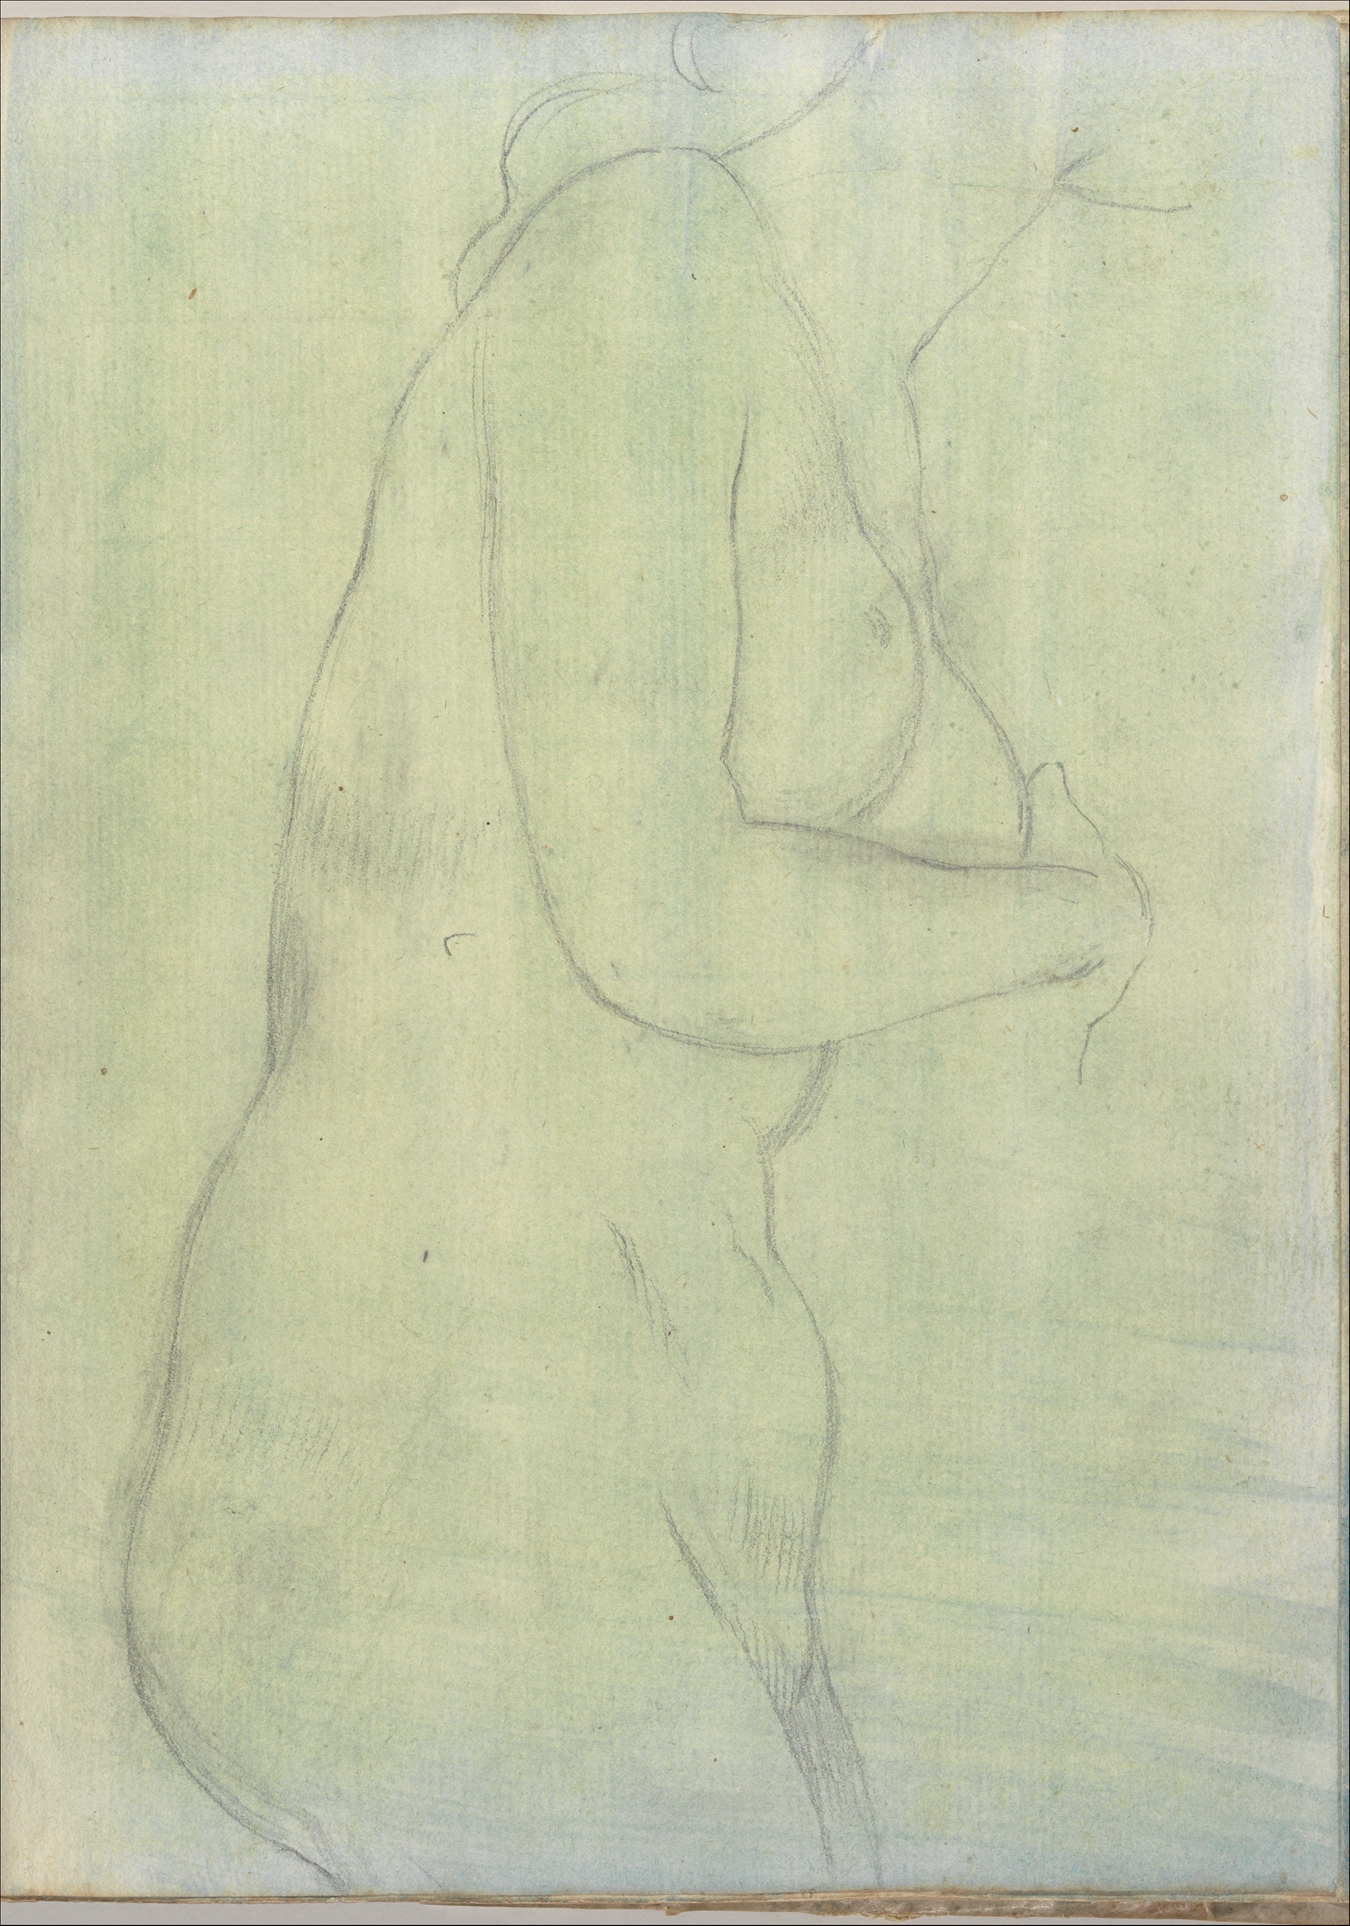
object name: drawing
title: Sketch of a female nude resembling the Medici Venus (Smaller Italian sketchbook, leaf 20 recto)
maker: joseph wright (wright of derby)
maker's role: artist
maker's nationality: british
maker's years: 1734-1797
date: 1774-1775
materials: graphite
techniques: brush, wash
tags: female nudes